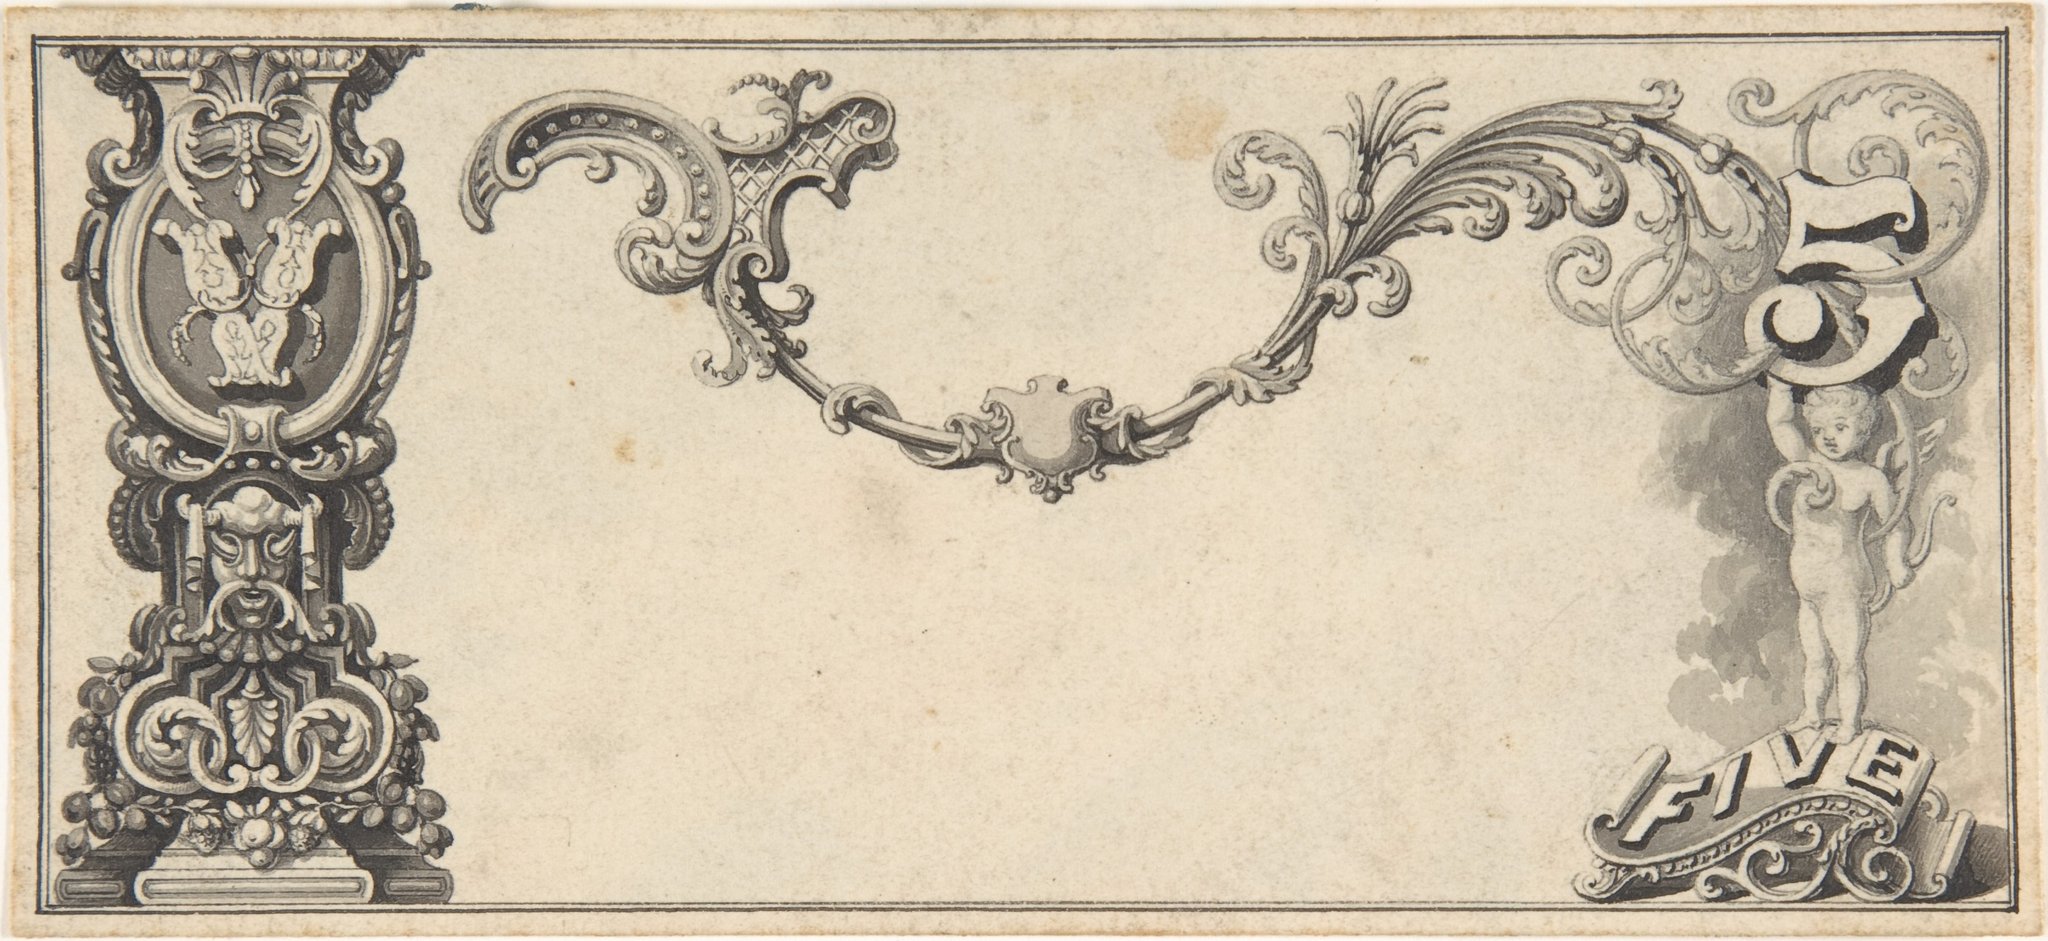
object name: drawing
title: Design for Banknote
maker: robert william hume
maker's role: artist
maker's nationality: british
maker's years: 1816-1904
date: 1830-1904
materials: graphite, ink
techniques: brush, pen, wash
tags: money